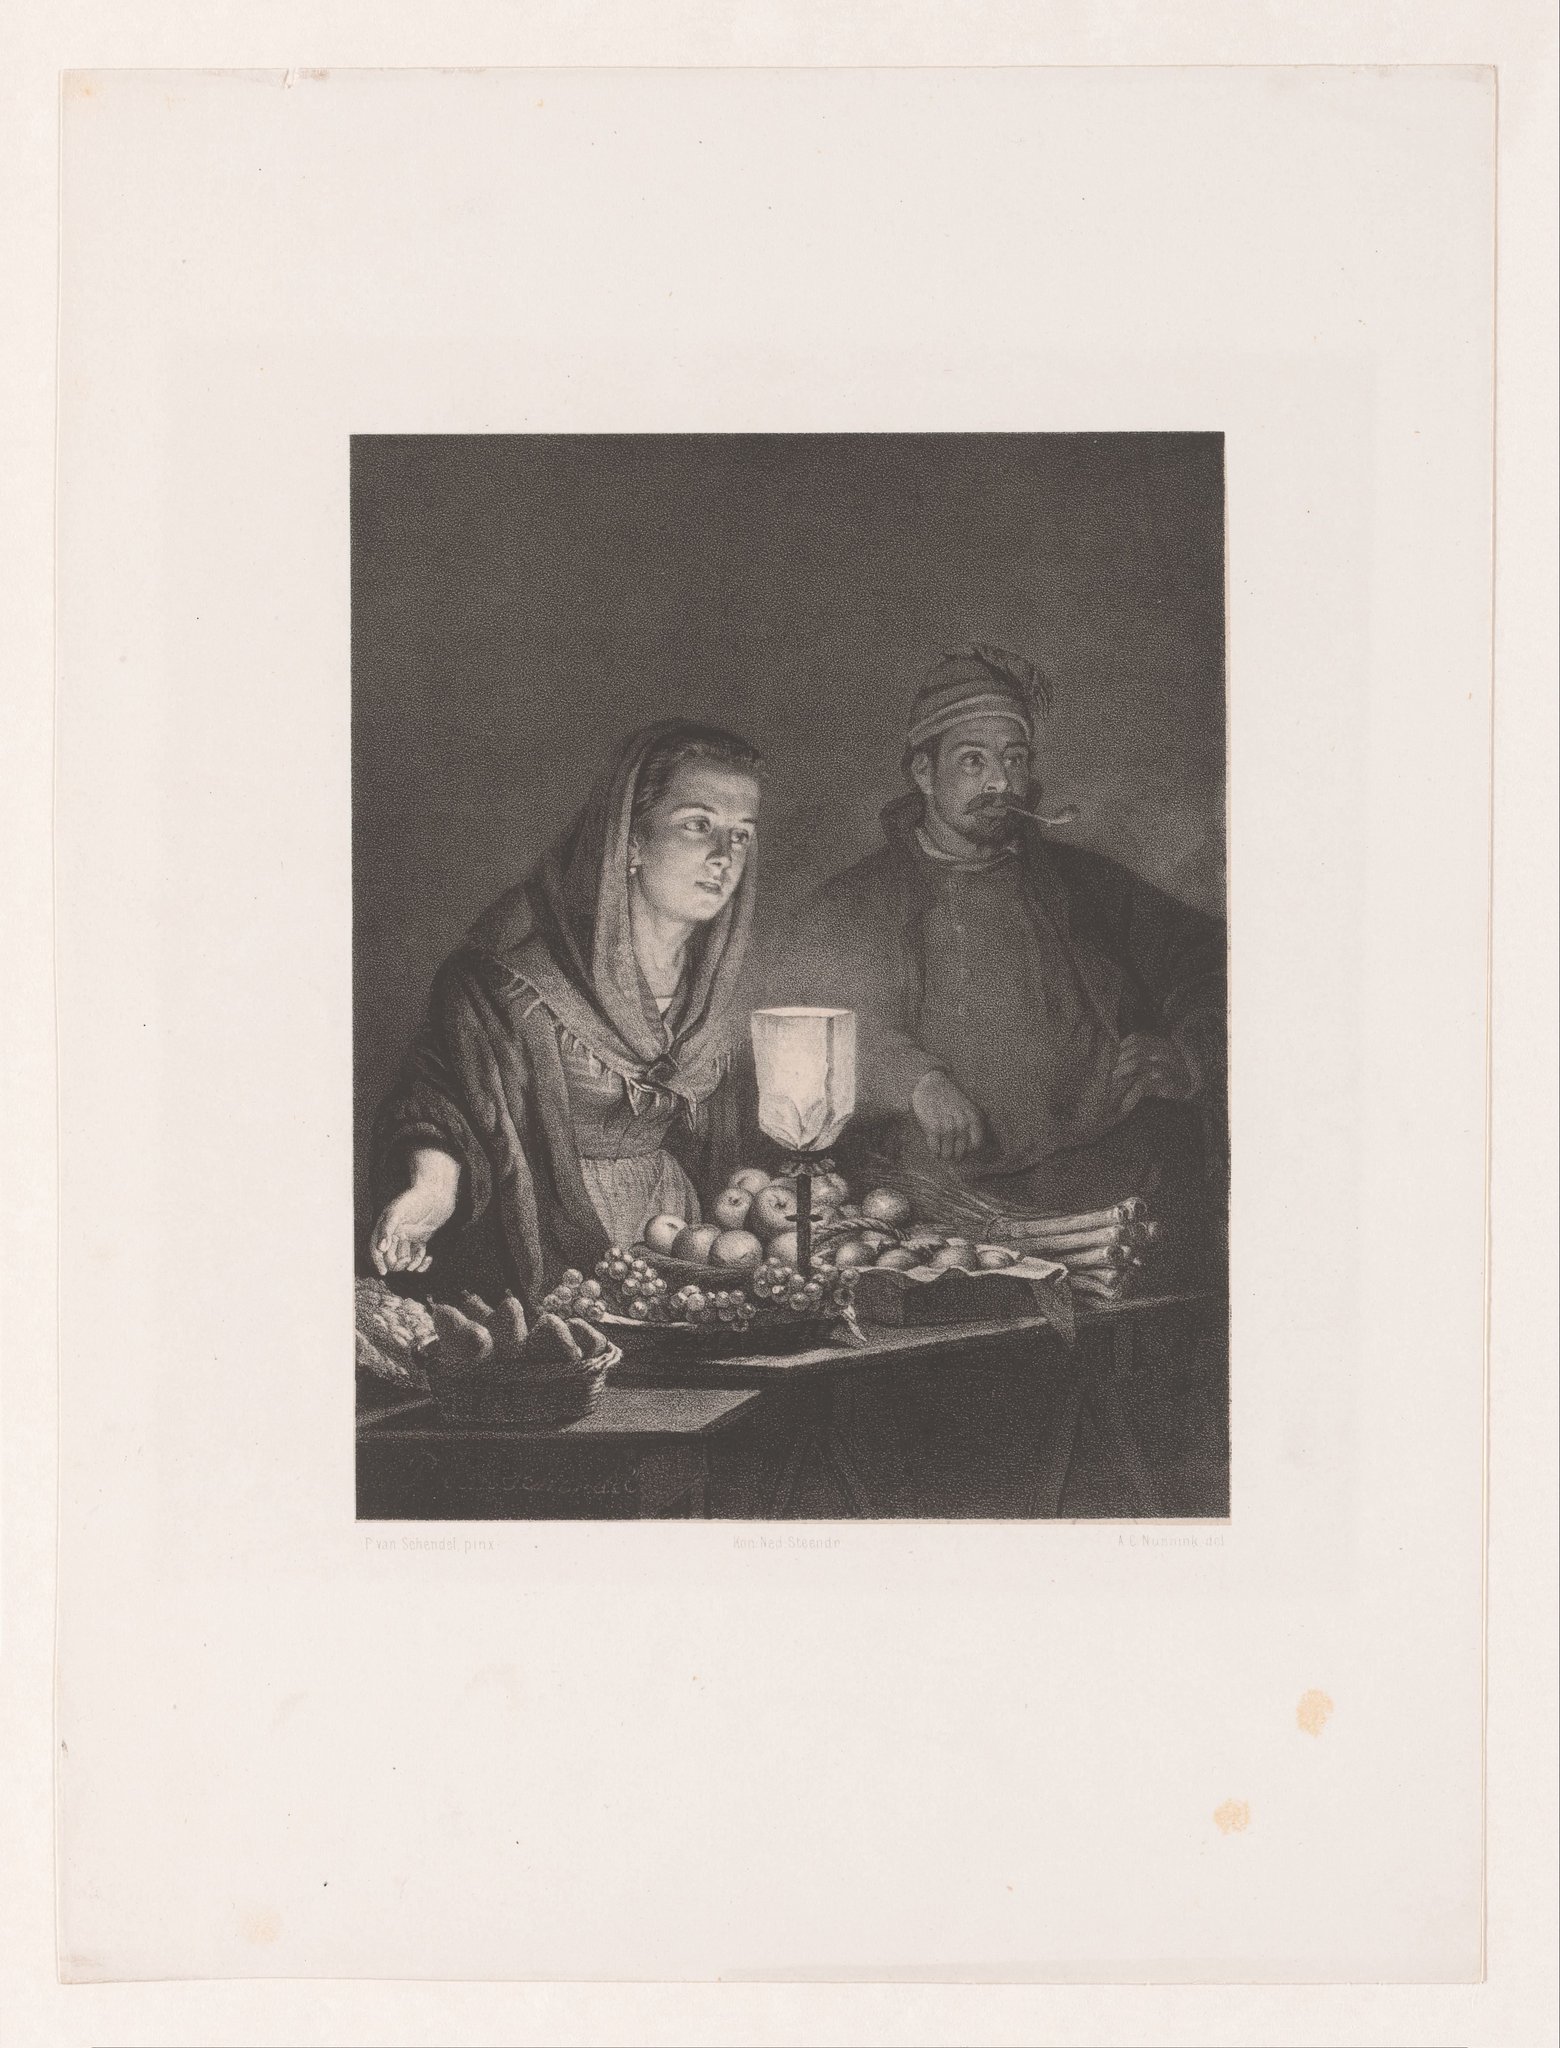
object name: print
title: Man en vrouw bij fruitkraam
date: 1867-1874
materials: paper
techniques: lithograph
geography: the hague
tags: fruit, stall, booth (~ market)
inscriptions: collector's mark: Lugt 2228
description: Een man en vrouw bij een groente- en fruitkraam, verlicht door een kaars.